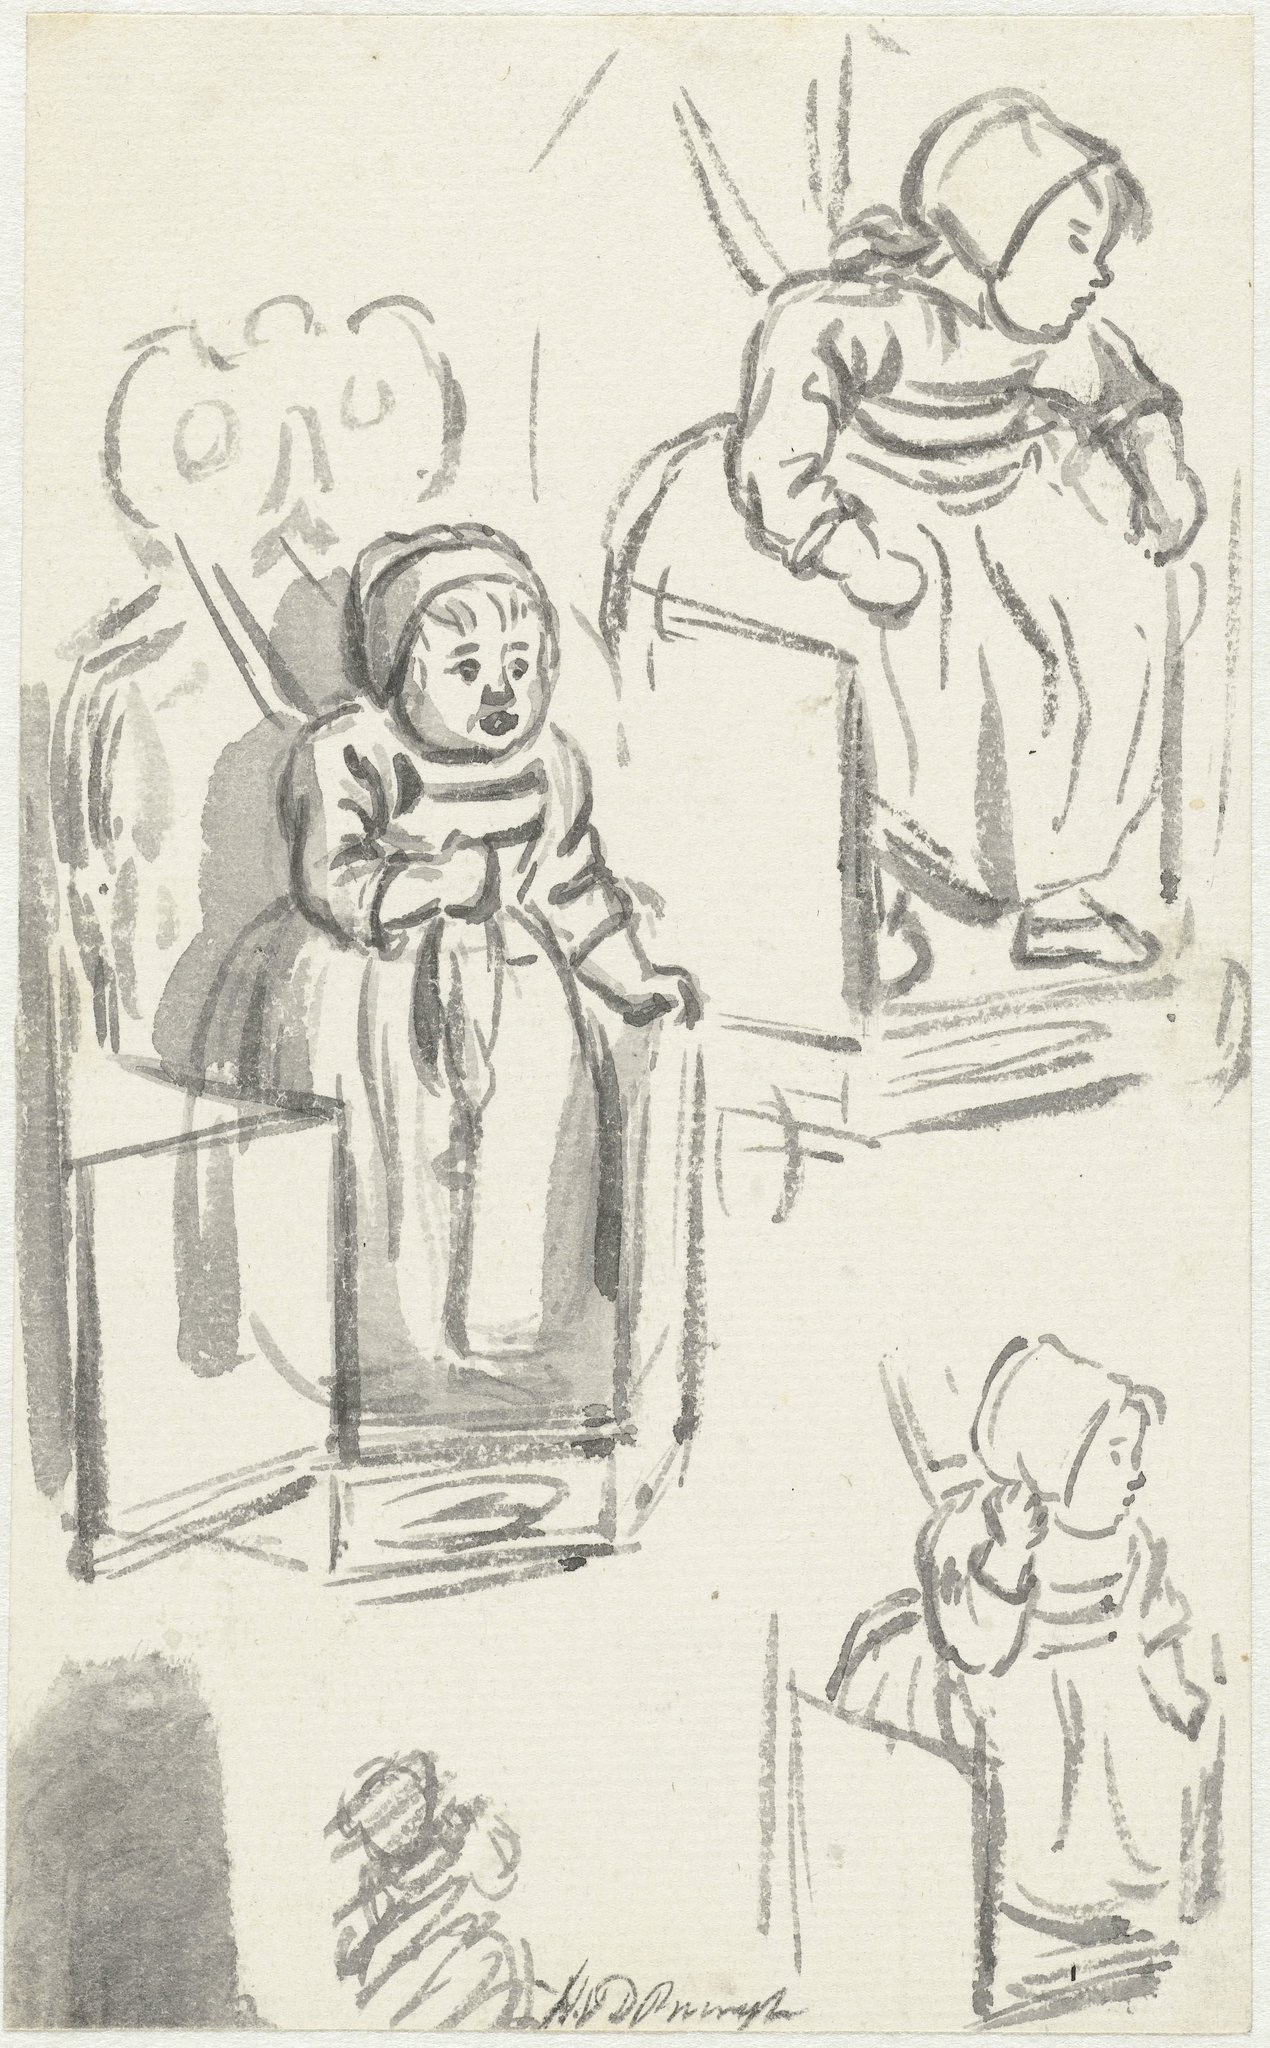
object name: drawing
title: Studies van een kind in een kinderstoel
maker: hendrik van der burgh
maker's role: draughtsman, print maker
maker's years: 1769-1858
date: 1779-1858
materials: paper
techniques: brush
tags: baby-chair